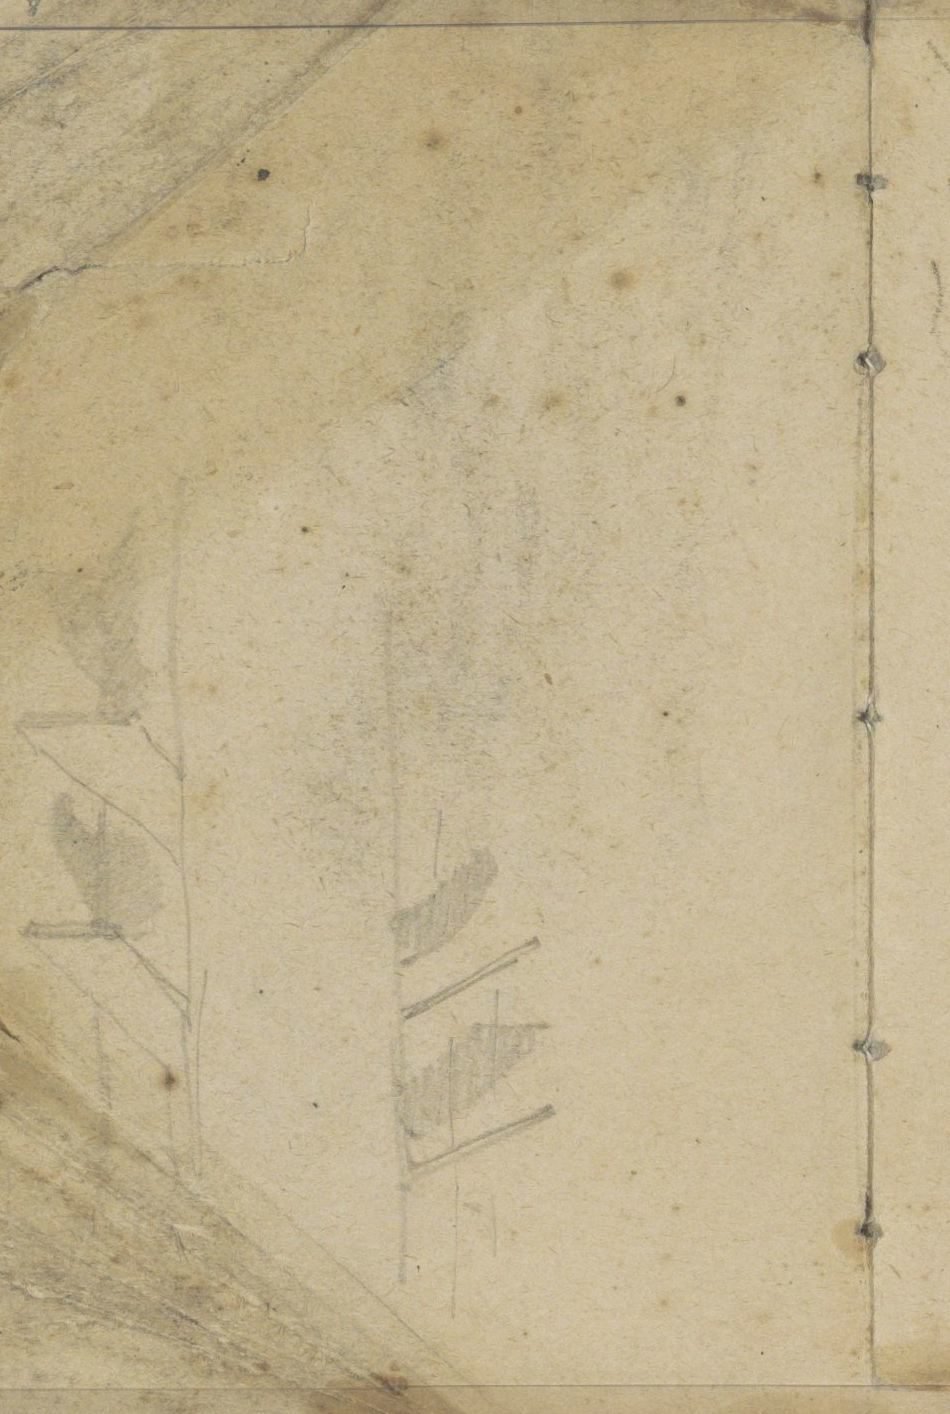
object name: sketchbook leaf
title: Studie, mogelijk van een boomstam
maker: george hendrik breitner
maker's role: draughtsman, painter, print maker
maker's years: 1857-1923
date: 1881-1883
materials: paper, pencil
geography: south holland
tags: trees (+ stem, trunk)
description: Studie, mogelijk van een boomstam. Pagina 8 uit een schetsboek met 43 bladen.